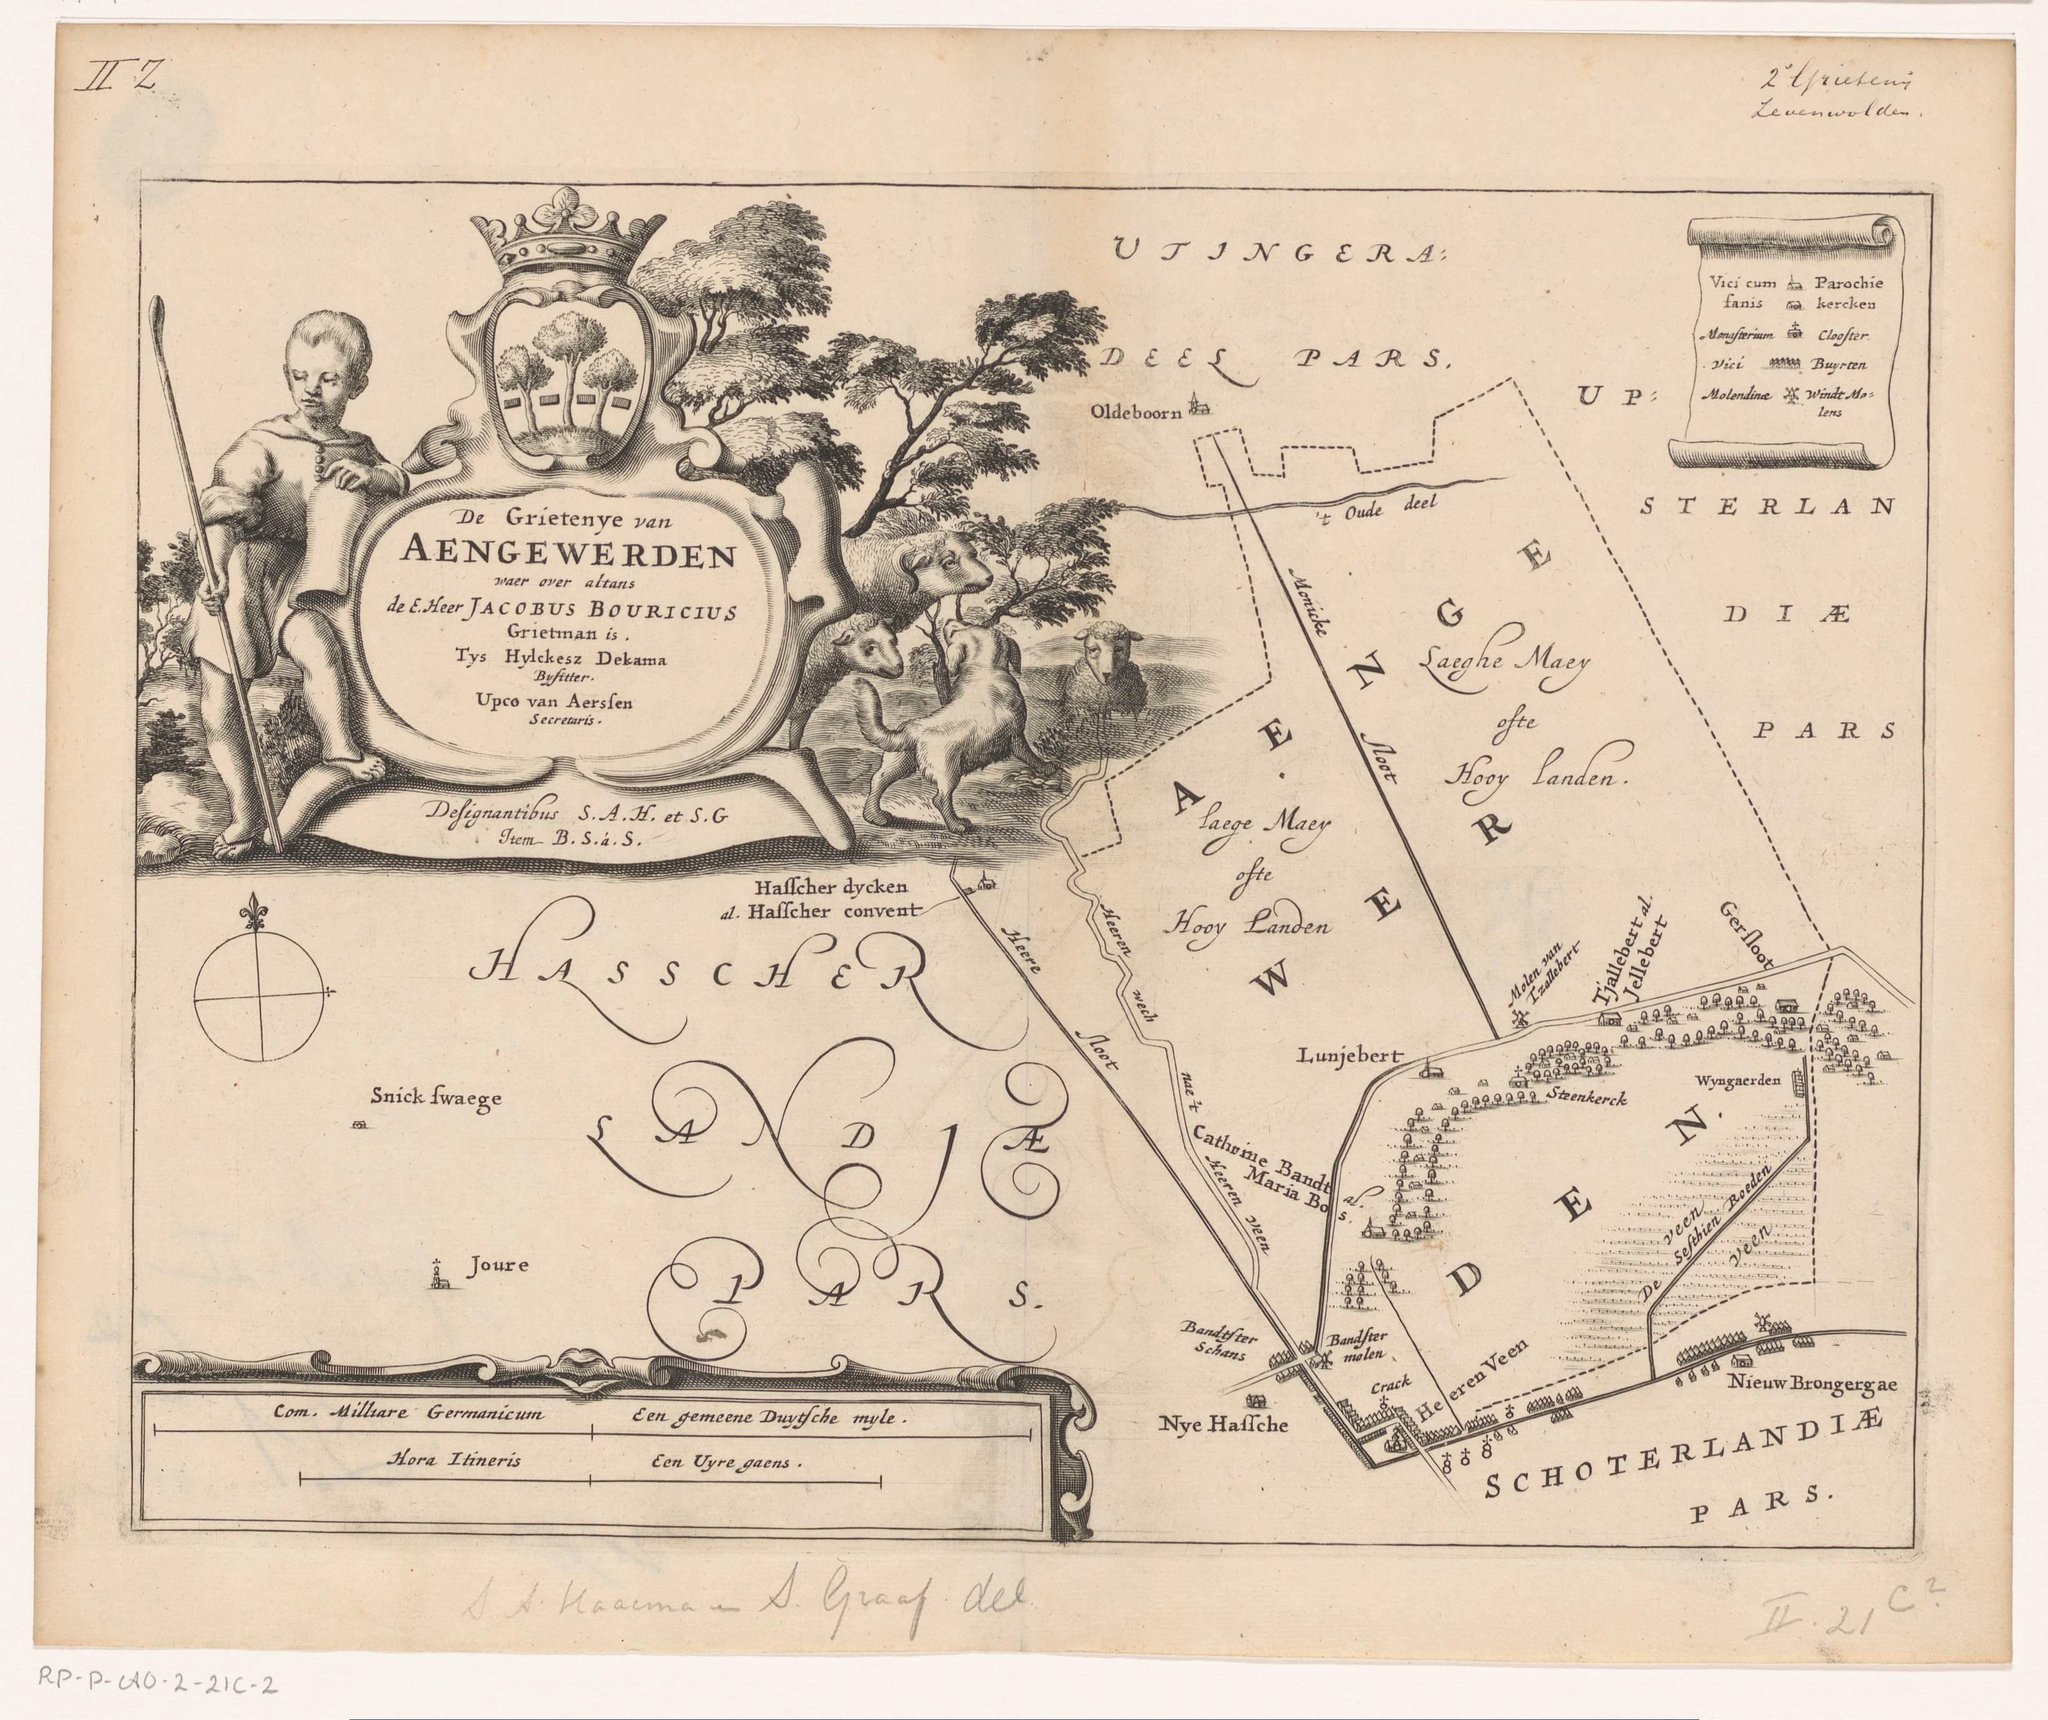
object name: print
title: De grietenye van Aengewerden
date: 1664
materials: paper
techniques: engraving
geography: friesland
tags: coat of arms (as symbol of the state, etc.), maps of separate countries or regions, herding, herdsman, herdswoman, shepherd, shepherdess, cowherd, etc.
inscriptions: collector's mark: Lugt 2228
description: Linksboven cartouche met het wapen van Aengwirden, titel en bestuurlijke informatie over de grietenij. Daaromheen een jongen met herdersstaf, een hond en schapen. Linksonder twee schaalstokken: Com. Milliare Germanicum / Een gemeene Duytsche myle, Hora itineris / Een uyre gaens. Rechtsboven legenda.